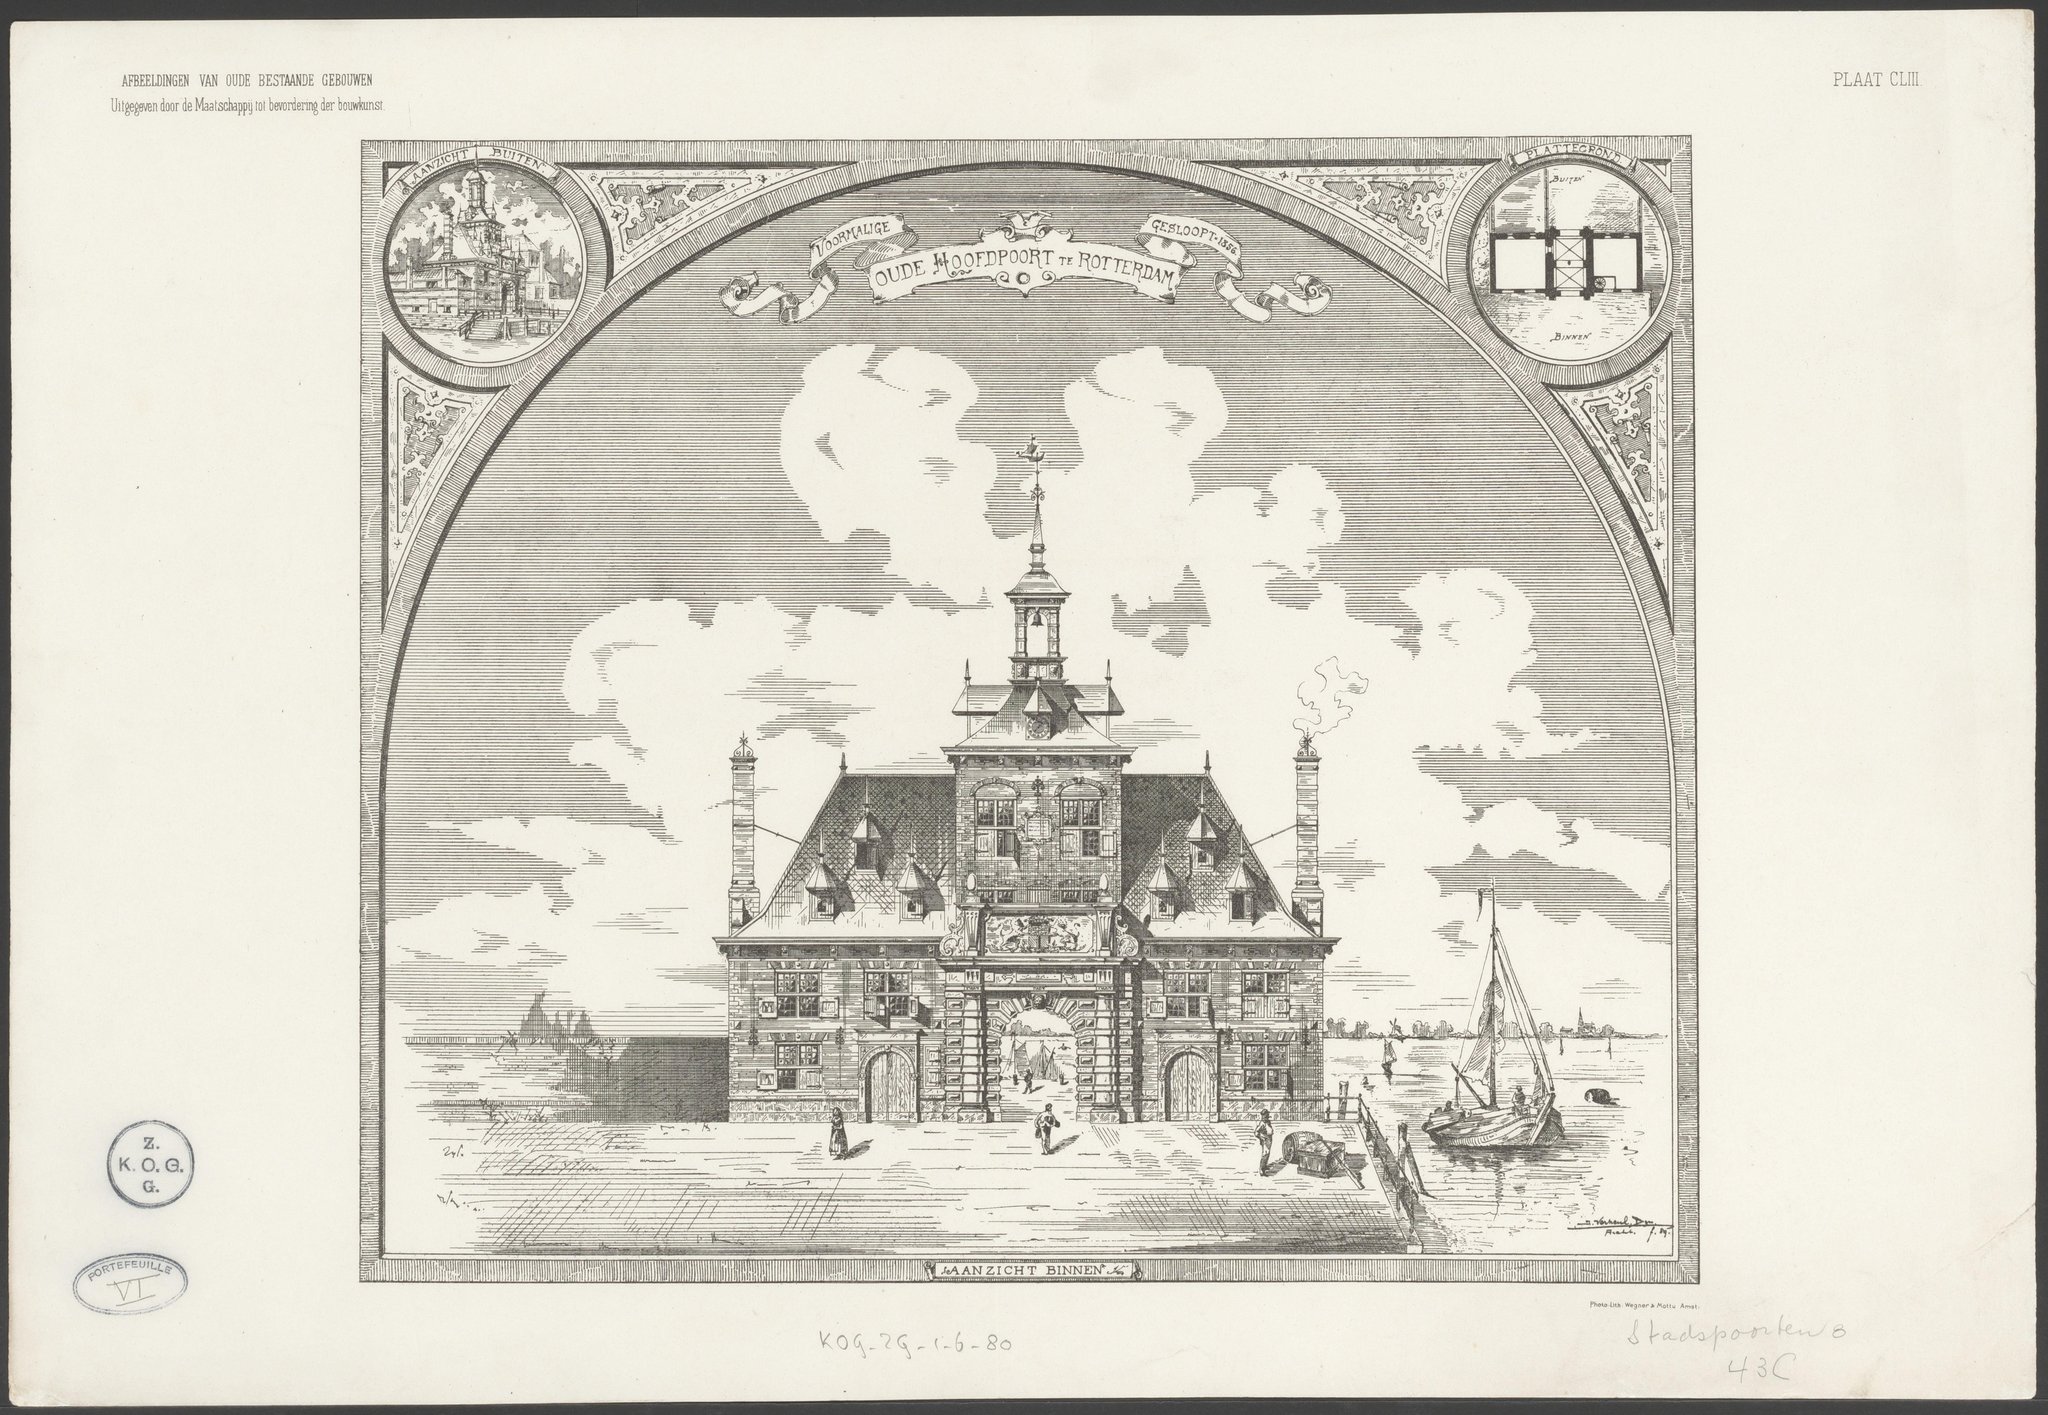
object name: photomechanical print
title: Voormalige oude Hoofdpoort te Rotterdam, Gesloopt 1856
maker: dirk verheul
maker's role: draughtsman, painter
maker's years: 1864-1949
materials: paper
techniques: photolithography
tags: plan ~ architecture, city-gate, leiden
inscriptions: collector's mark: Lugt 1641, stamp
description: Rechtsboven genummerd: Plaat CLIII. Onderwerpsrubrieken binnen de Atlas Zeden en Gewoonten: Krijgswezen, Stadspoorten.